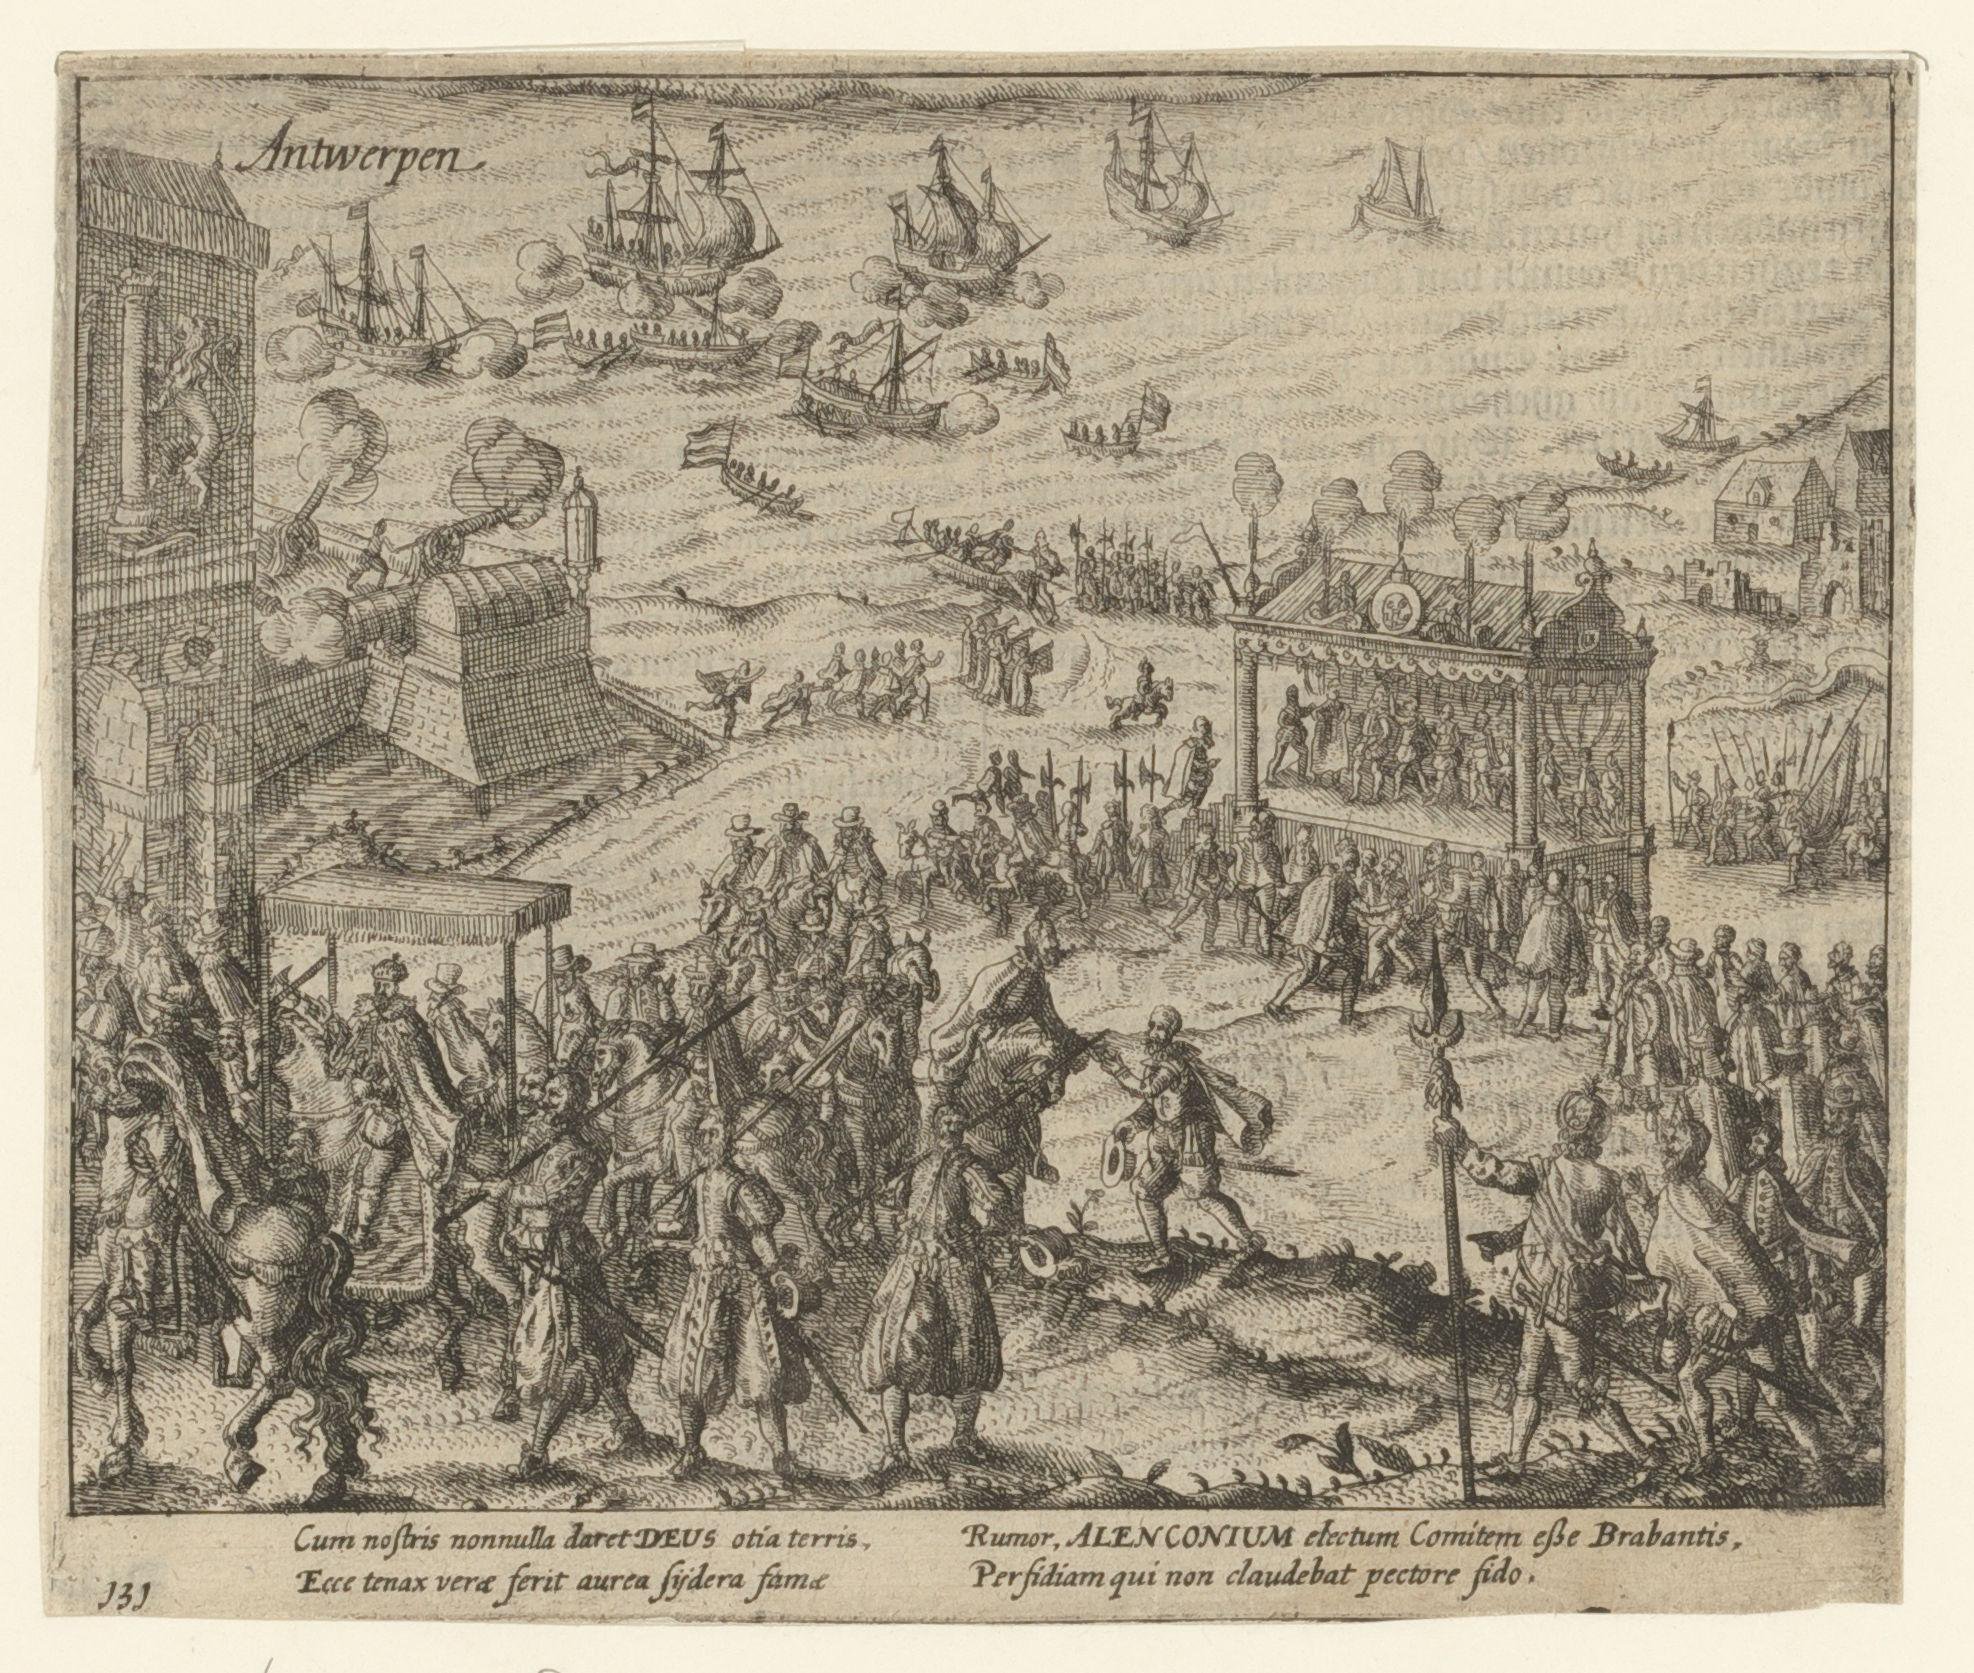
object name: history print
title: Aankomst van de hertog van Anjou te Antwerpen, 1582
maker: Anonymous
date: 1613-1615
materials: paper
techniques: etching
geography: northern netherlands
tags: delft, william i (prince of orange), françois-hercule de valois (hertog van anjou), triumphal entry and public reception, pageant, 'entrée solennelle', 'joyeuse entrée', antwerp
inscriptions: collector's mark, collector's mark: Lugt 1641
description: Aankomst van Anjou te Antwerpen, 19 februari 1582. Hij wordt begroet door Willem van Oranje, op een podium krijgt hij de mantel en hoed van de hertog van Brabant, op de voorgrond trekt de stoet de stad in. Met onderschrift van 4 regels in het Latijn. Genummerd 131. Bedrukt op achterzijde met tekst in het Nederlands. Onderwerpsrubrieken binnen de Atlas Zeden en Gewoonten: Krijgswezen; prenten van Baudart. 80j. oorlog.